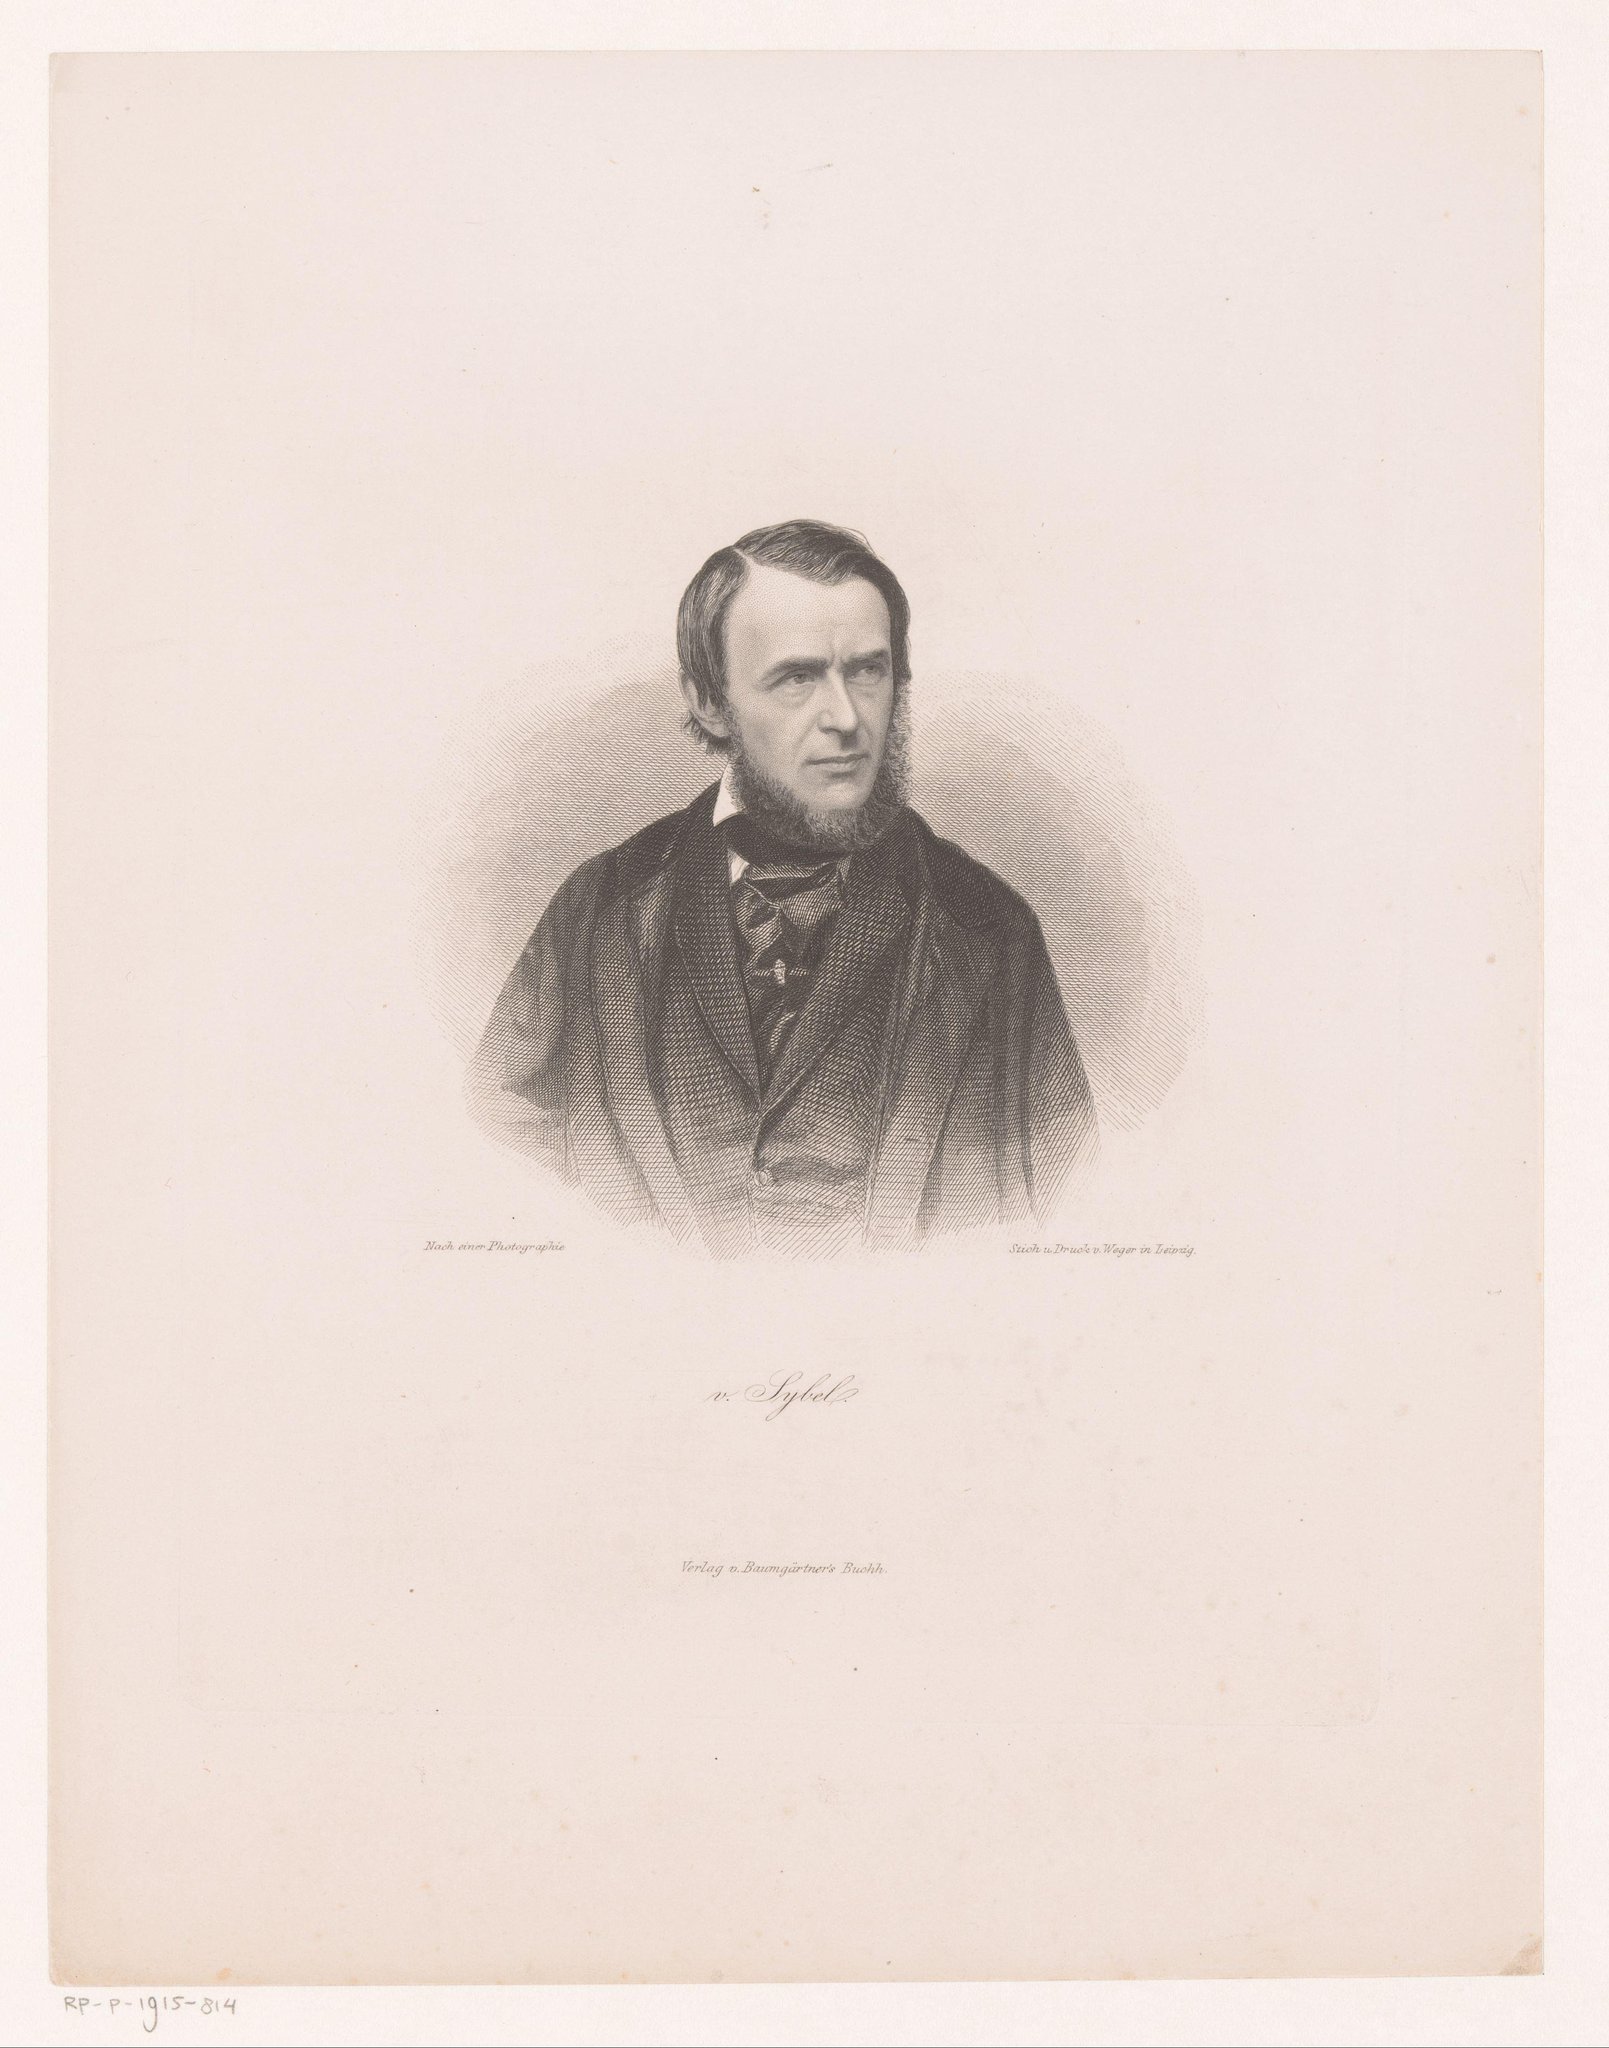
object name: print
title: Portret van Heinrich von Sybel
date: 1855-1892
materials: paper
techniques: engraving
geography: leipzig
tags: politician, historical persons, politician, e.g. party leader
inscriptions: collector's mark: Lugt 2228